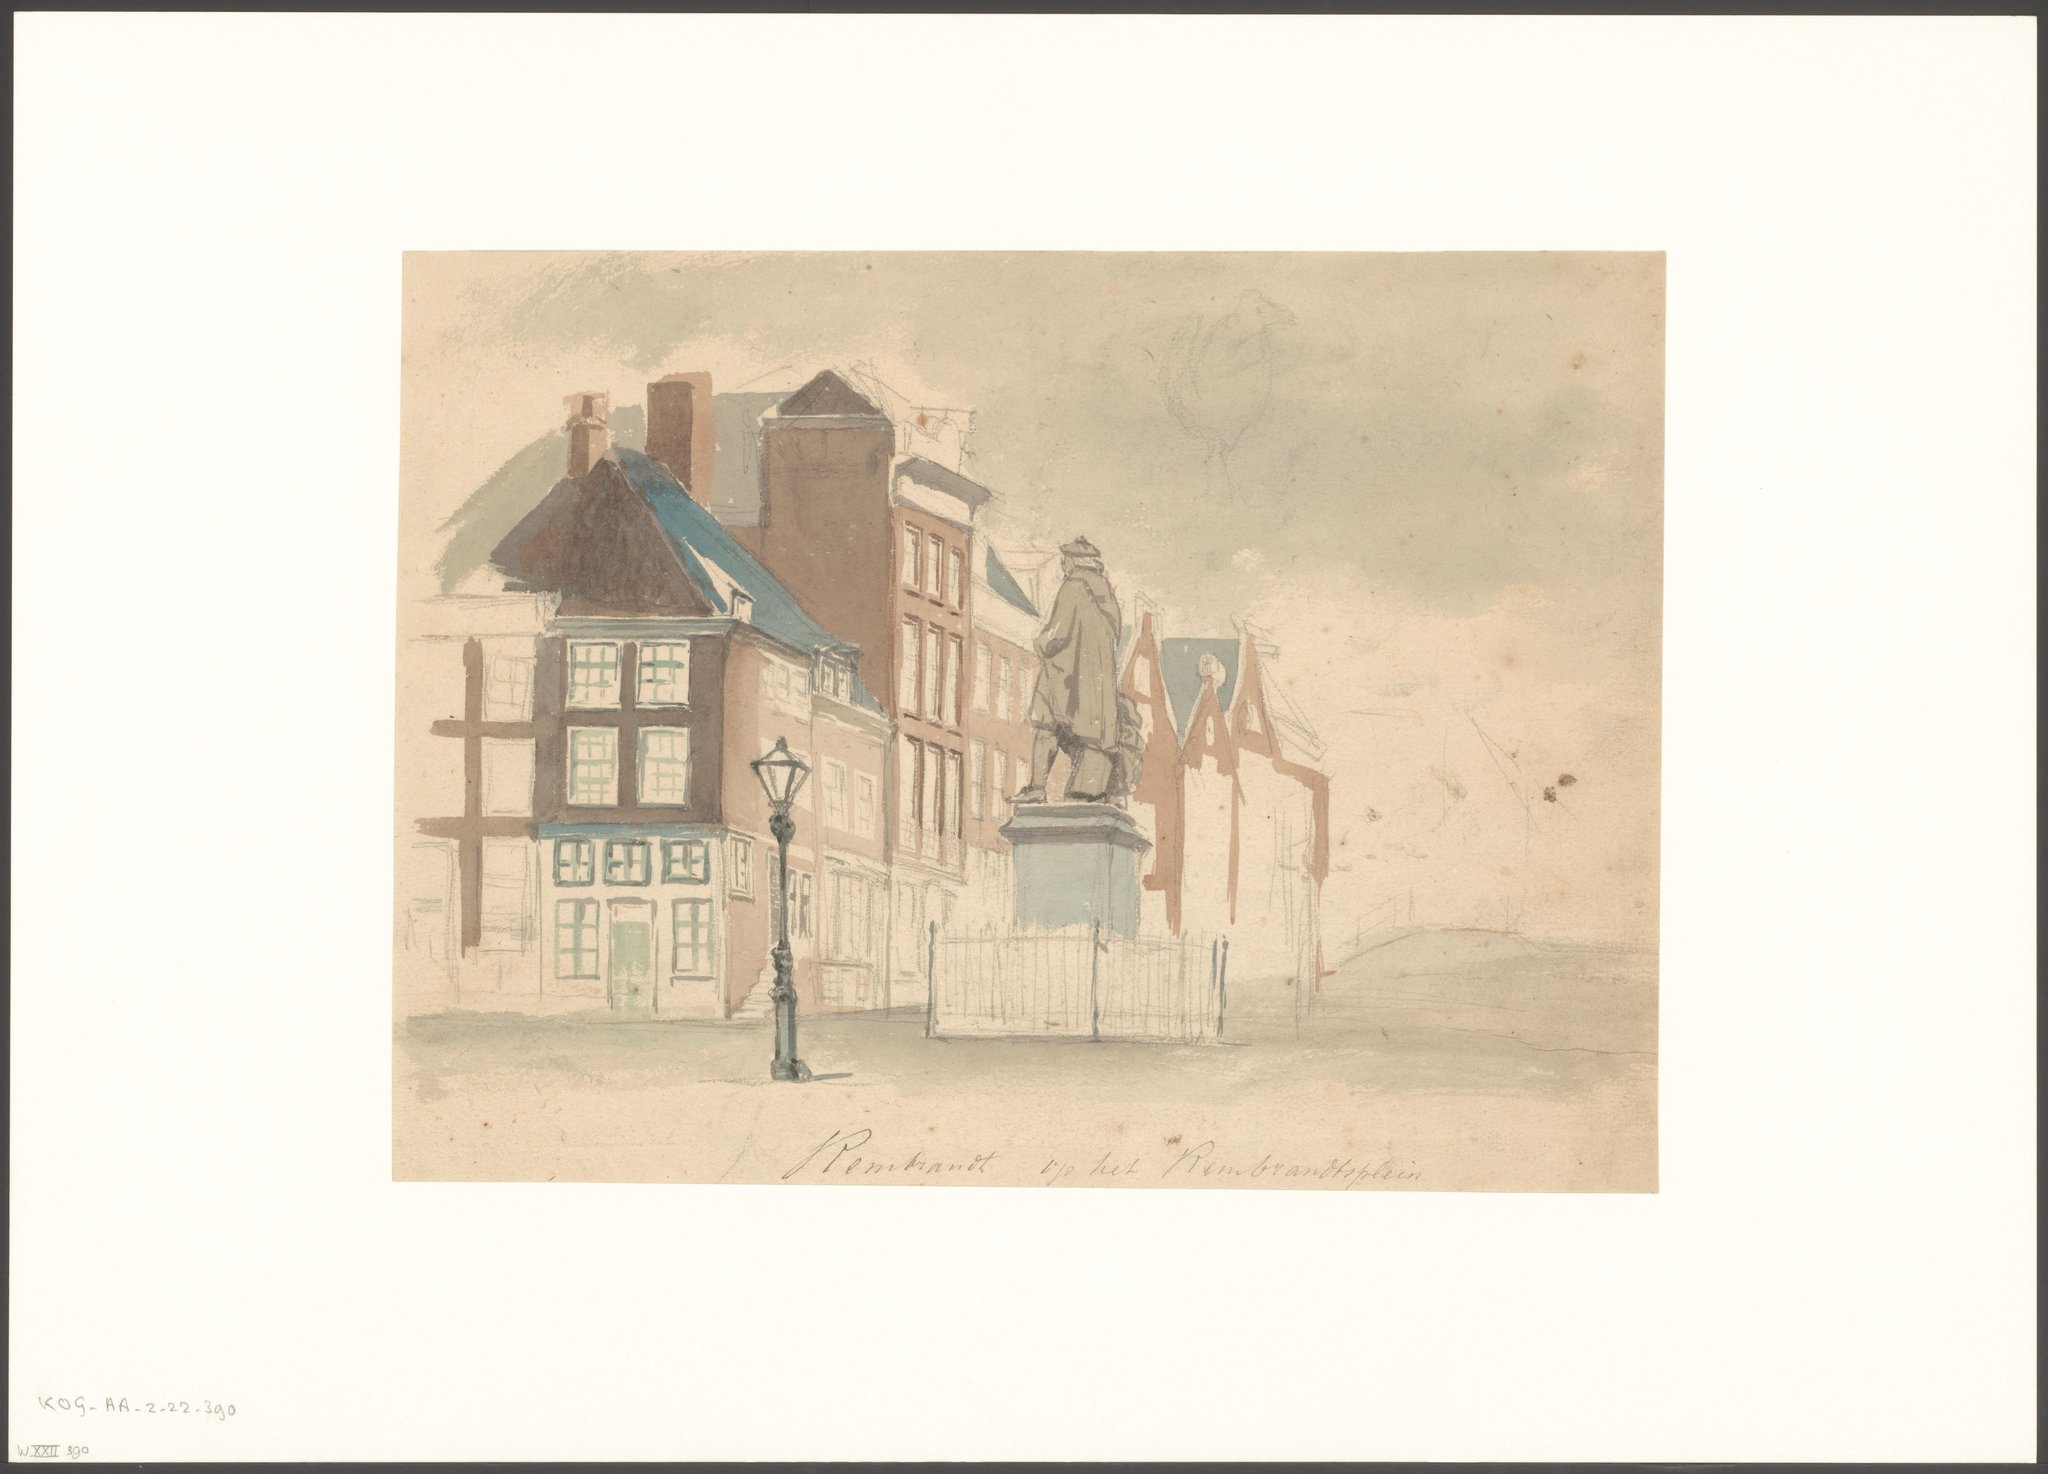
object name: drawing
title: Gezicht op het Rembrandtmonument op het Rembrandtplein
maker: Anonymous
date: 1852-1899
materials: paper, pencil, watercolor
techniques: brush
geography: amsterdam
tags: square, place, circus, etc., city-view in general; 'veduta', monument, statue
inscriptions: inscription: ‘Rembrandt op het Rembrandtsplein’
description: Tekening binnen de Atlas Van Eck ingedeeld op wijknummer 22.